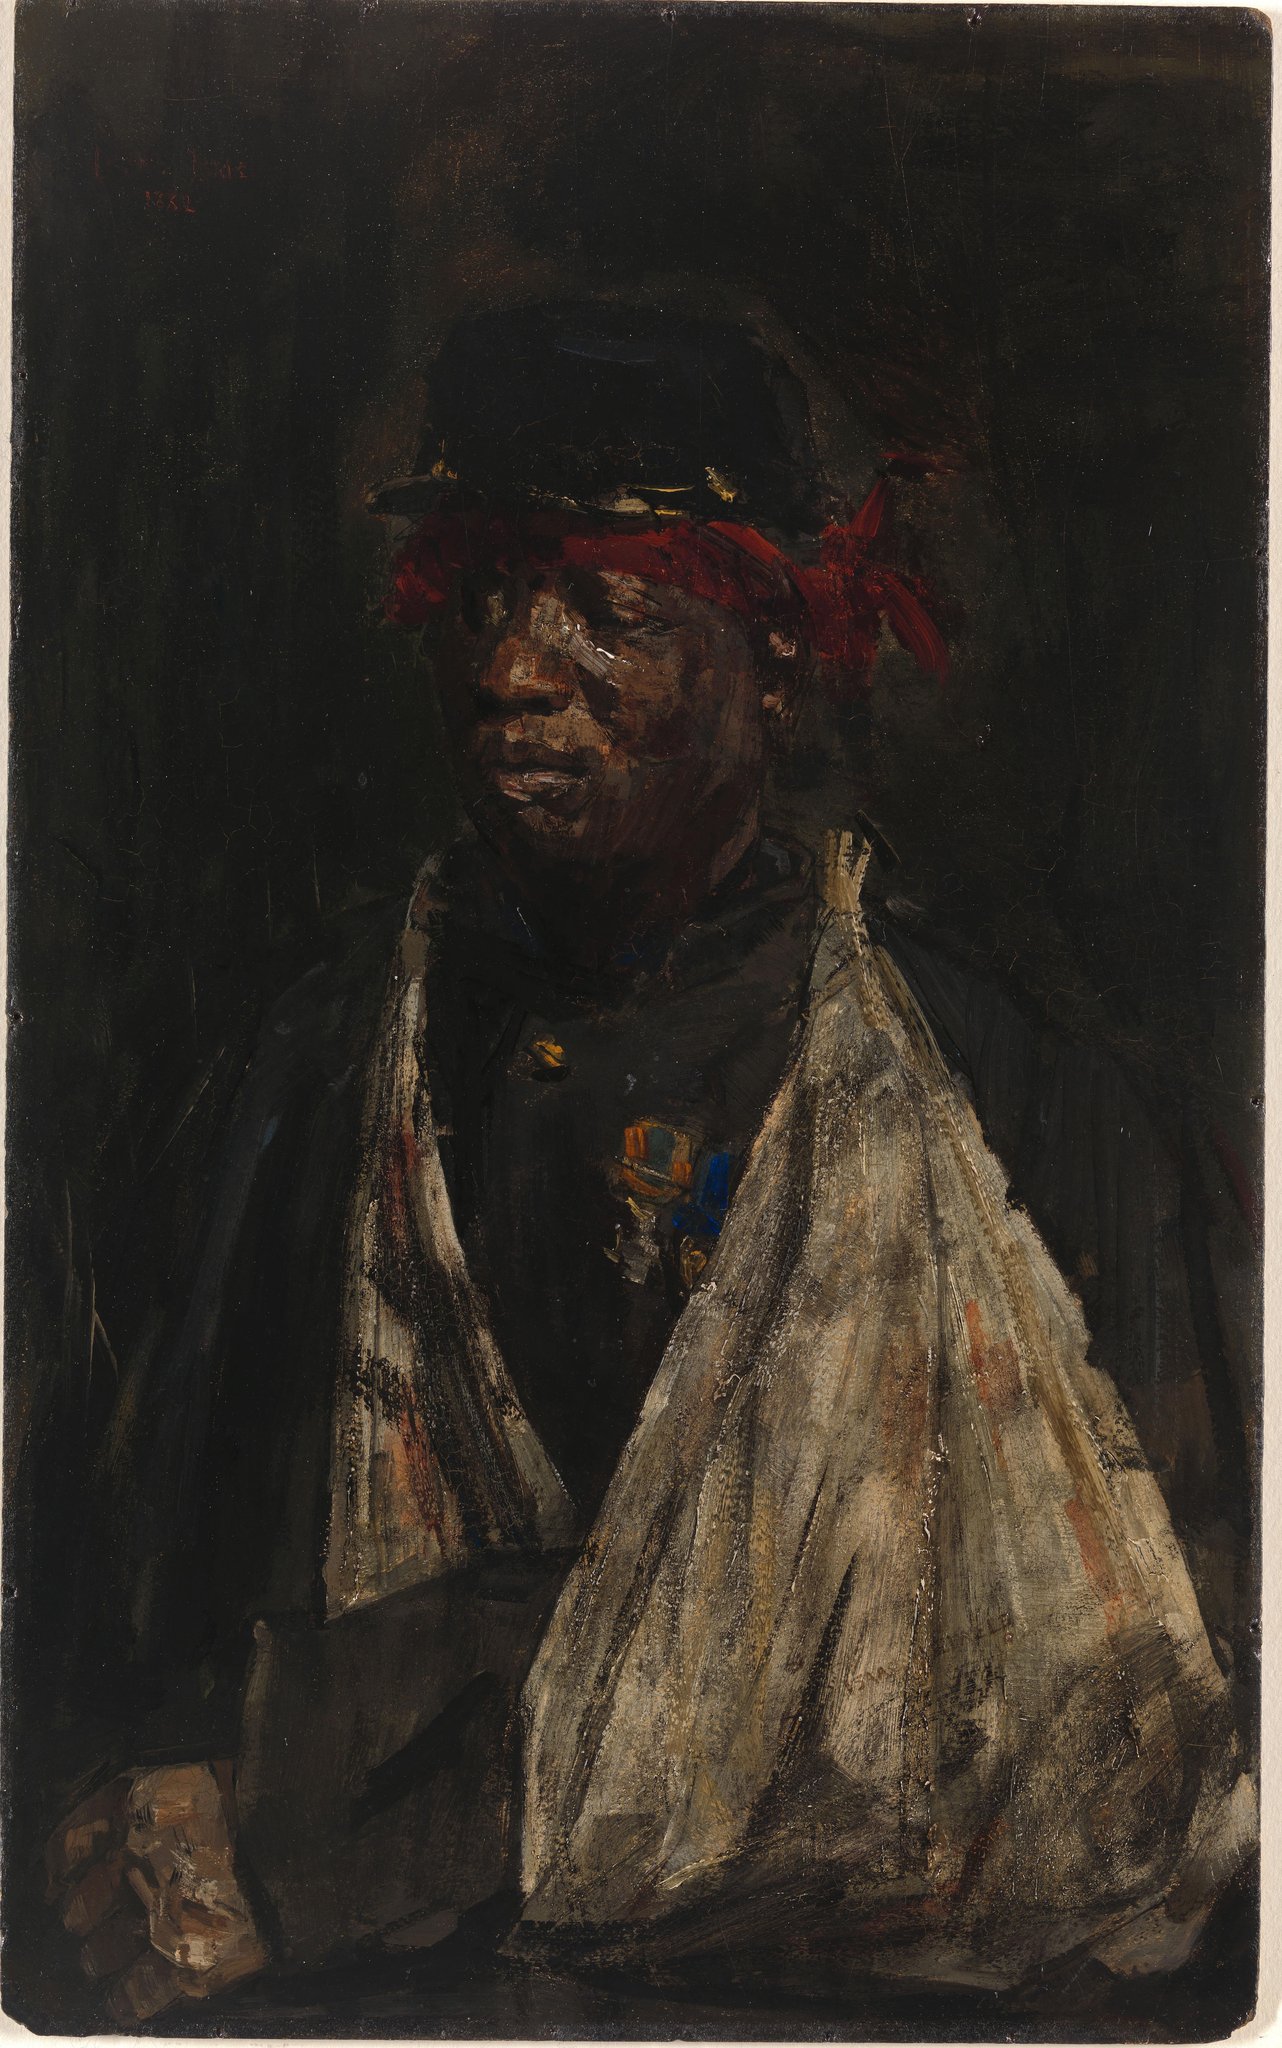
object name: painting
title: Portrait of a Wounded KNIL soldier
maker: isaac israels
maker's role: draughtsman, painter, print maker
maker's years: 1865-1934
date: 1882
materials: board, oil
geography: harderwijk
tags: veteran, disabled soldier, medals and other marks of military honour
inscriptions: signature and date: ‘Isaac Israels 1882’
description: After joining the Royal Netherlands East Indies Army (KNIL) in the former slave fortress of Elmina, Ghana, this man was called Kees Pop. His own name is unknown, but his parents were known as Kwamena and Ekoerva. ‘Pop’ served twelve years and fought in the Aceh War in Indonesia. Israëls painted him – with medals – while he was on sick leave in the Netherlands shortly before he returned to Africa.